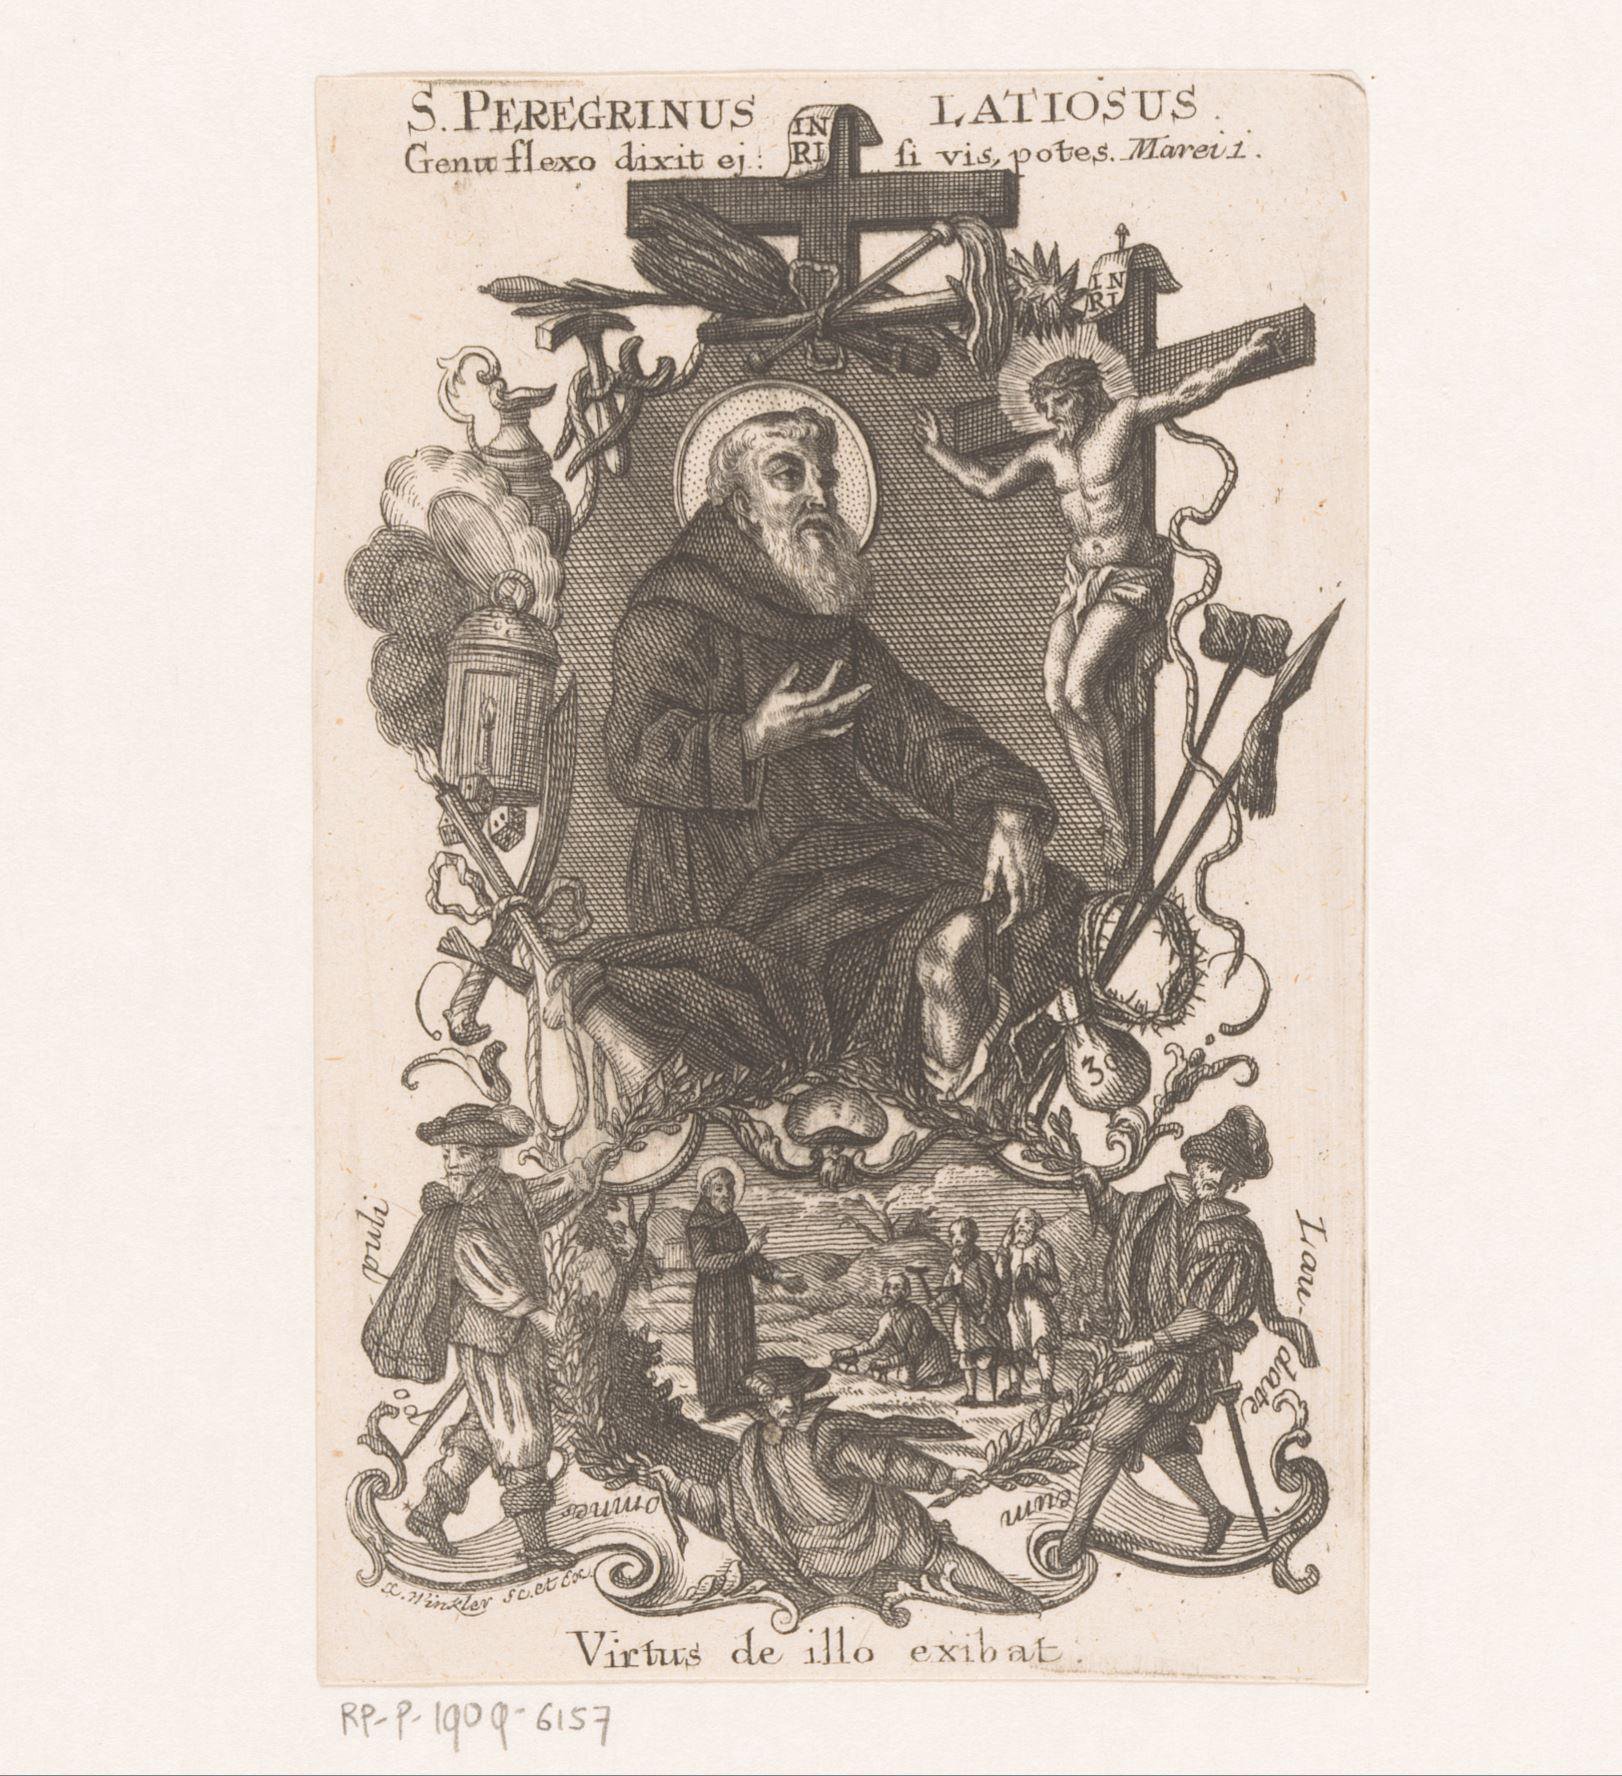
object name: print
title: Heilige Peregrine Laziosi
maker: johann christoph winkler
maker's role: metalworkers, print maker, publisher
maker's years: 1701-1770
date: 1717-1770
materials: paper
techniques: engraving, etching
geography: germany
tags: single instruments of the passion, crucifix ~ personal devotion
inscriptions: collector's mark: Lugt 2228